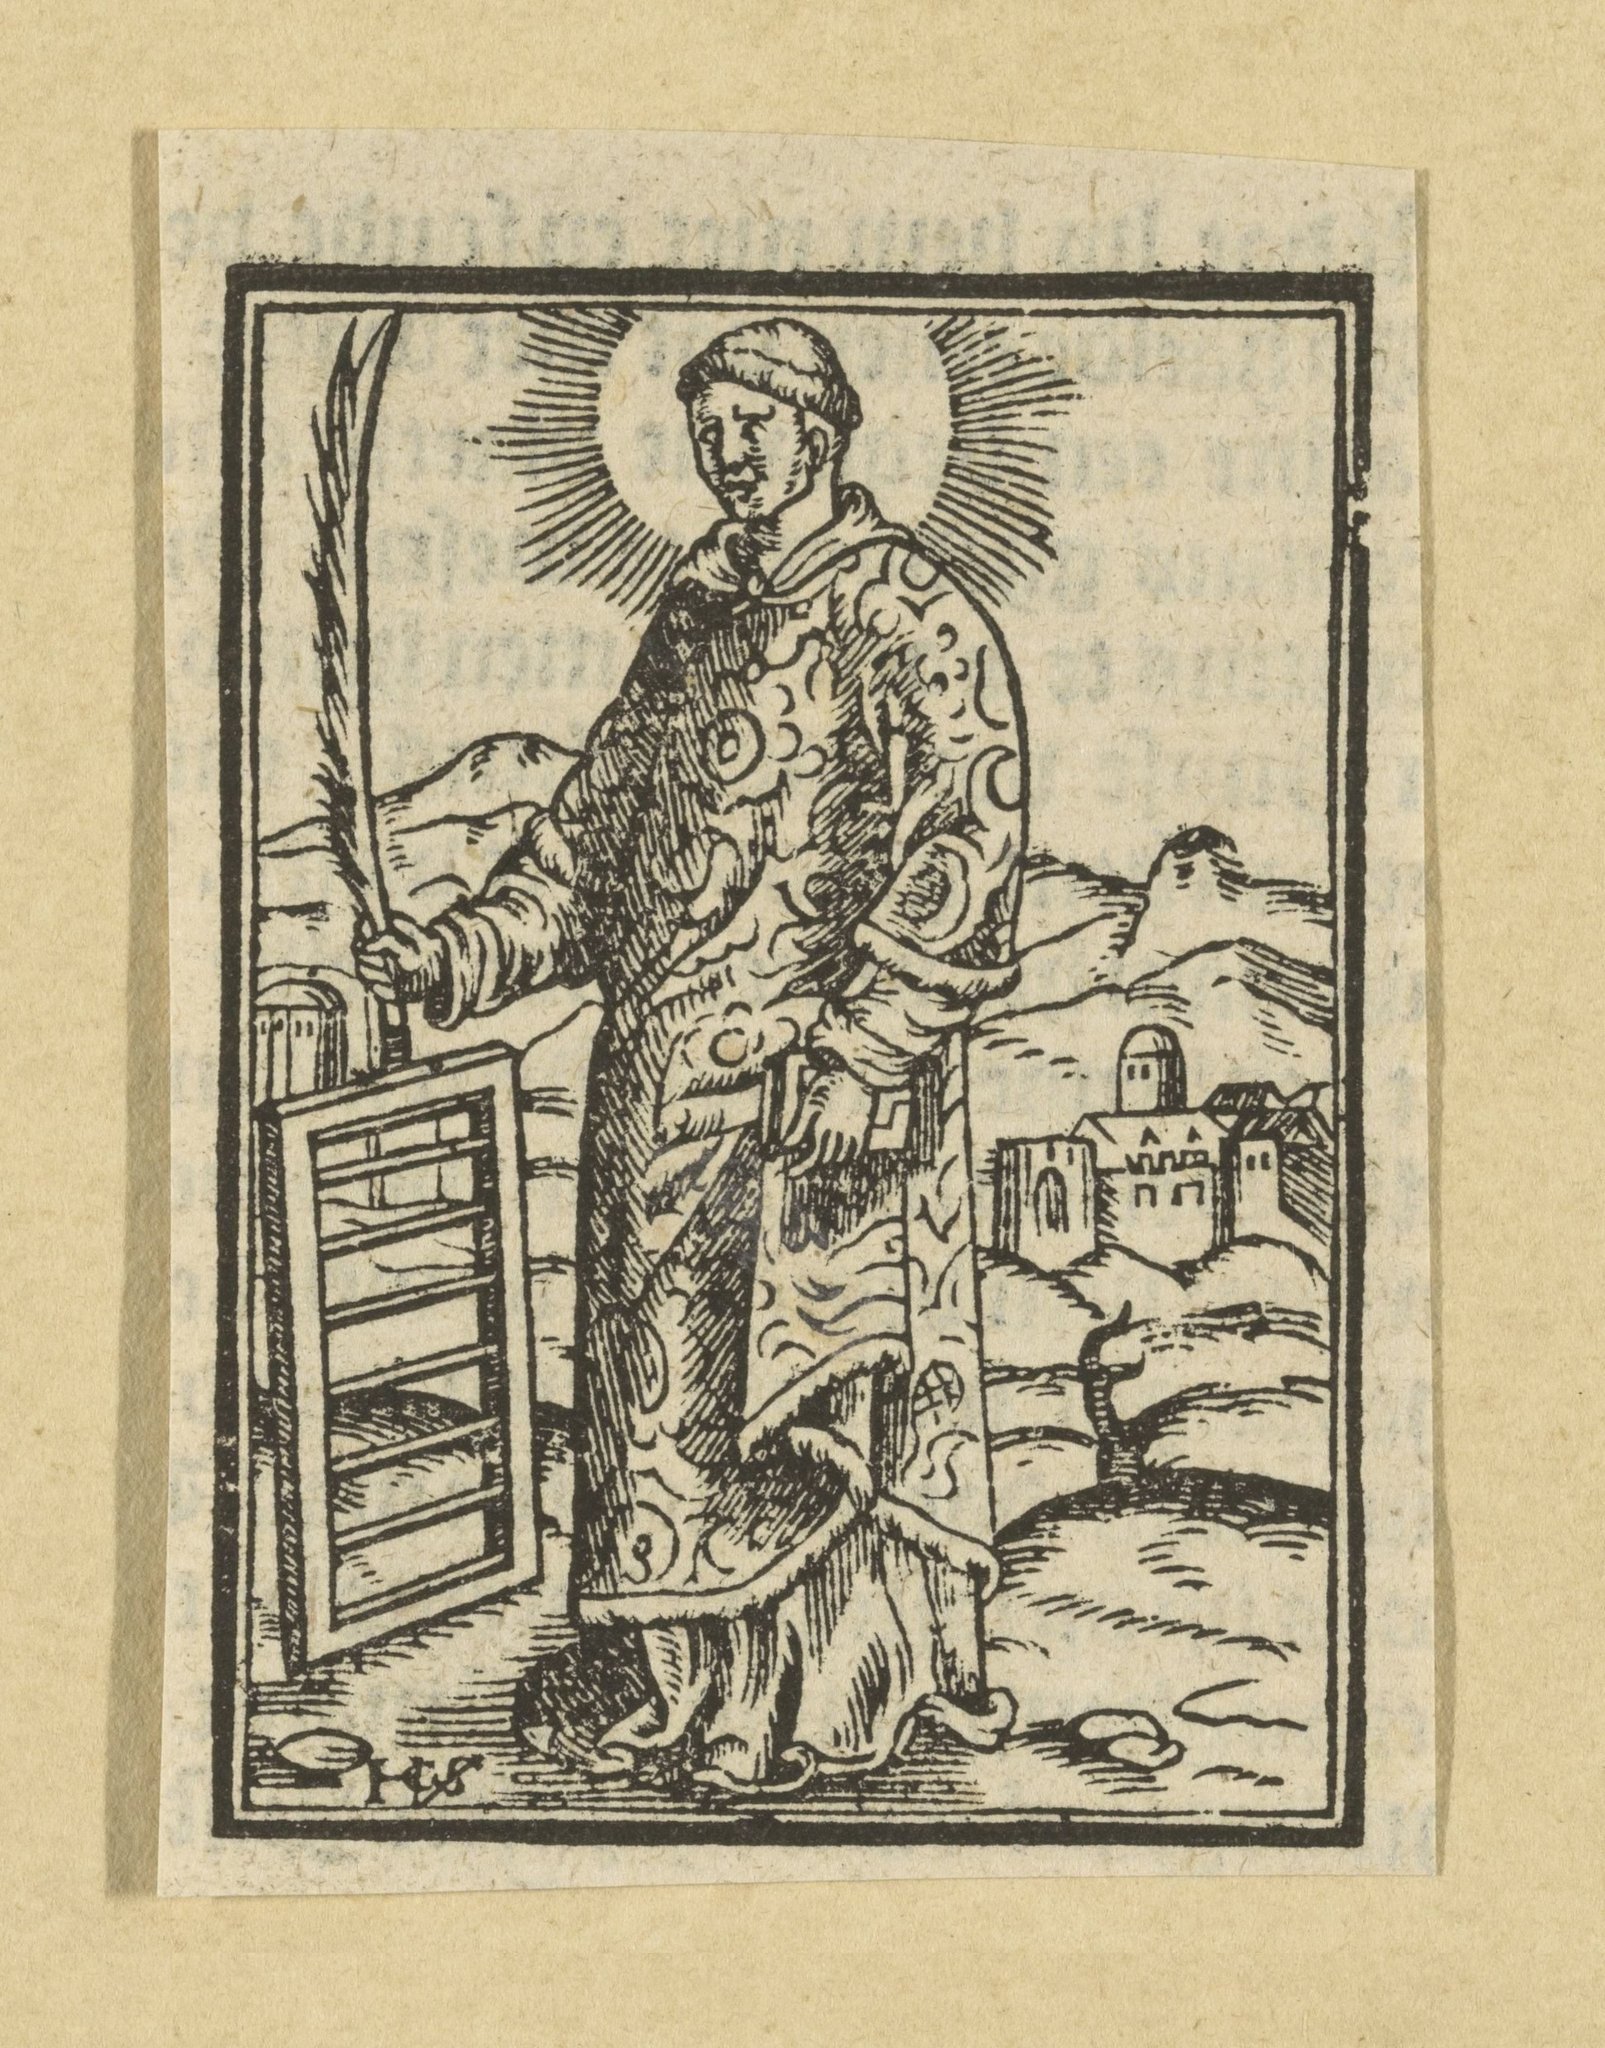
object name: book illustration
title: Heilige bij een hek in een berglandschap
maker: monogrammist hcvs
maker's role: print maker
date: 1600-1699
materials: paper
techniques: letterpress printing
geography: netherlands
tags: saints, mountains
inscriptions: collector's mark: Lugt 2228